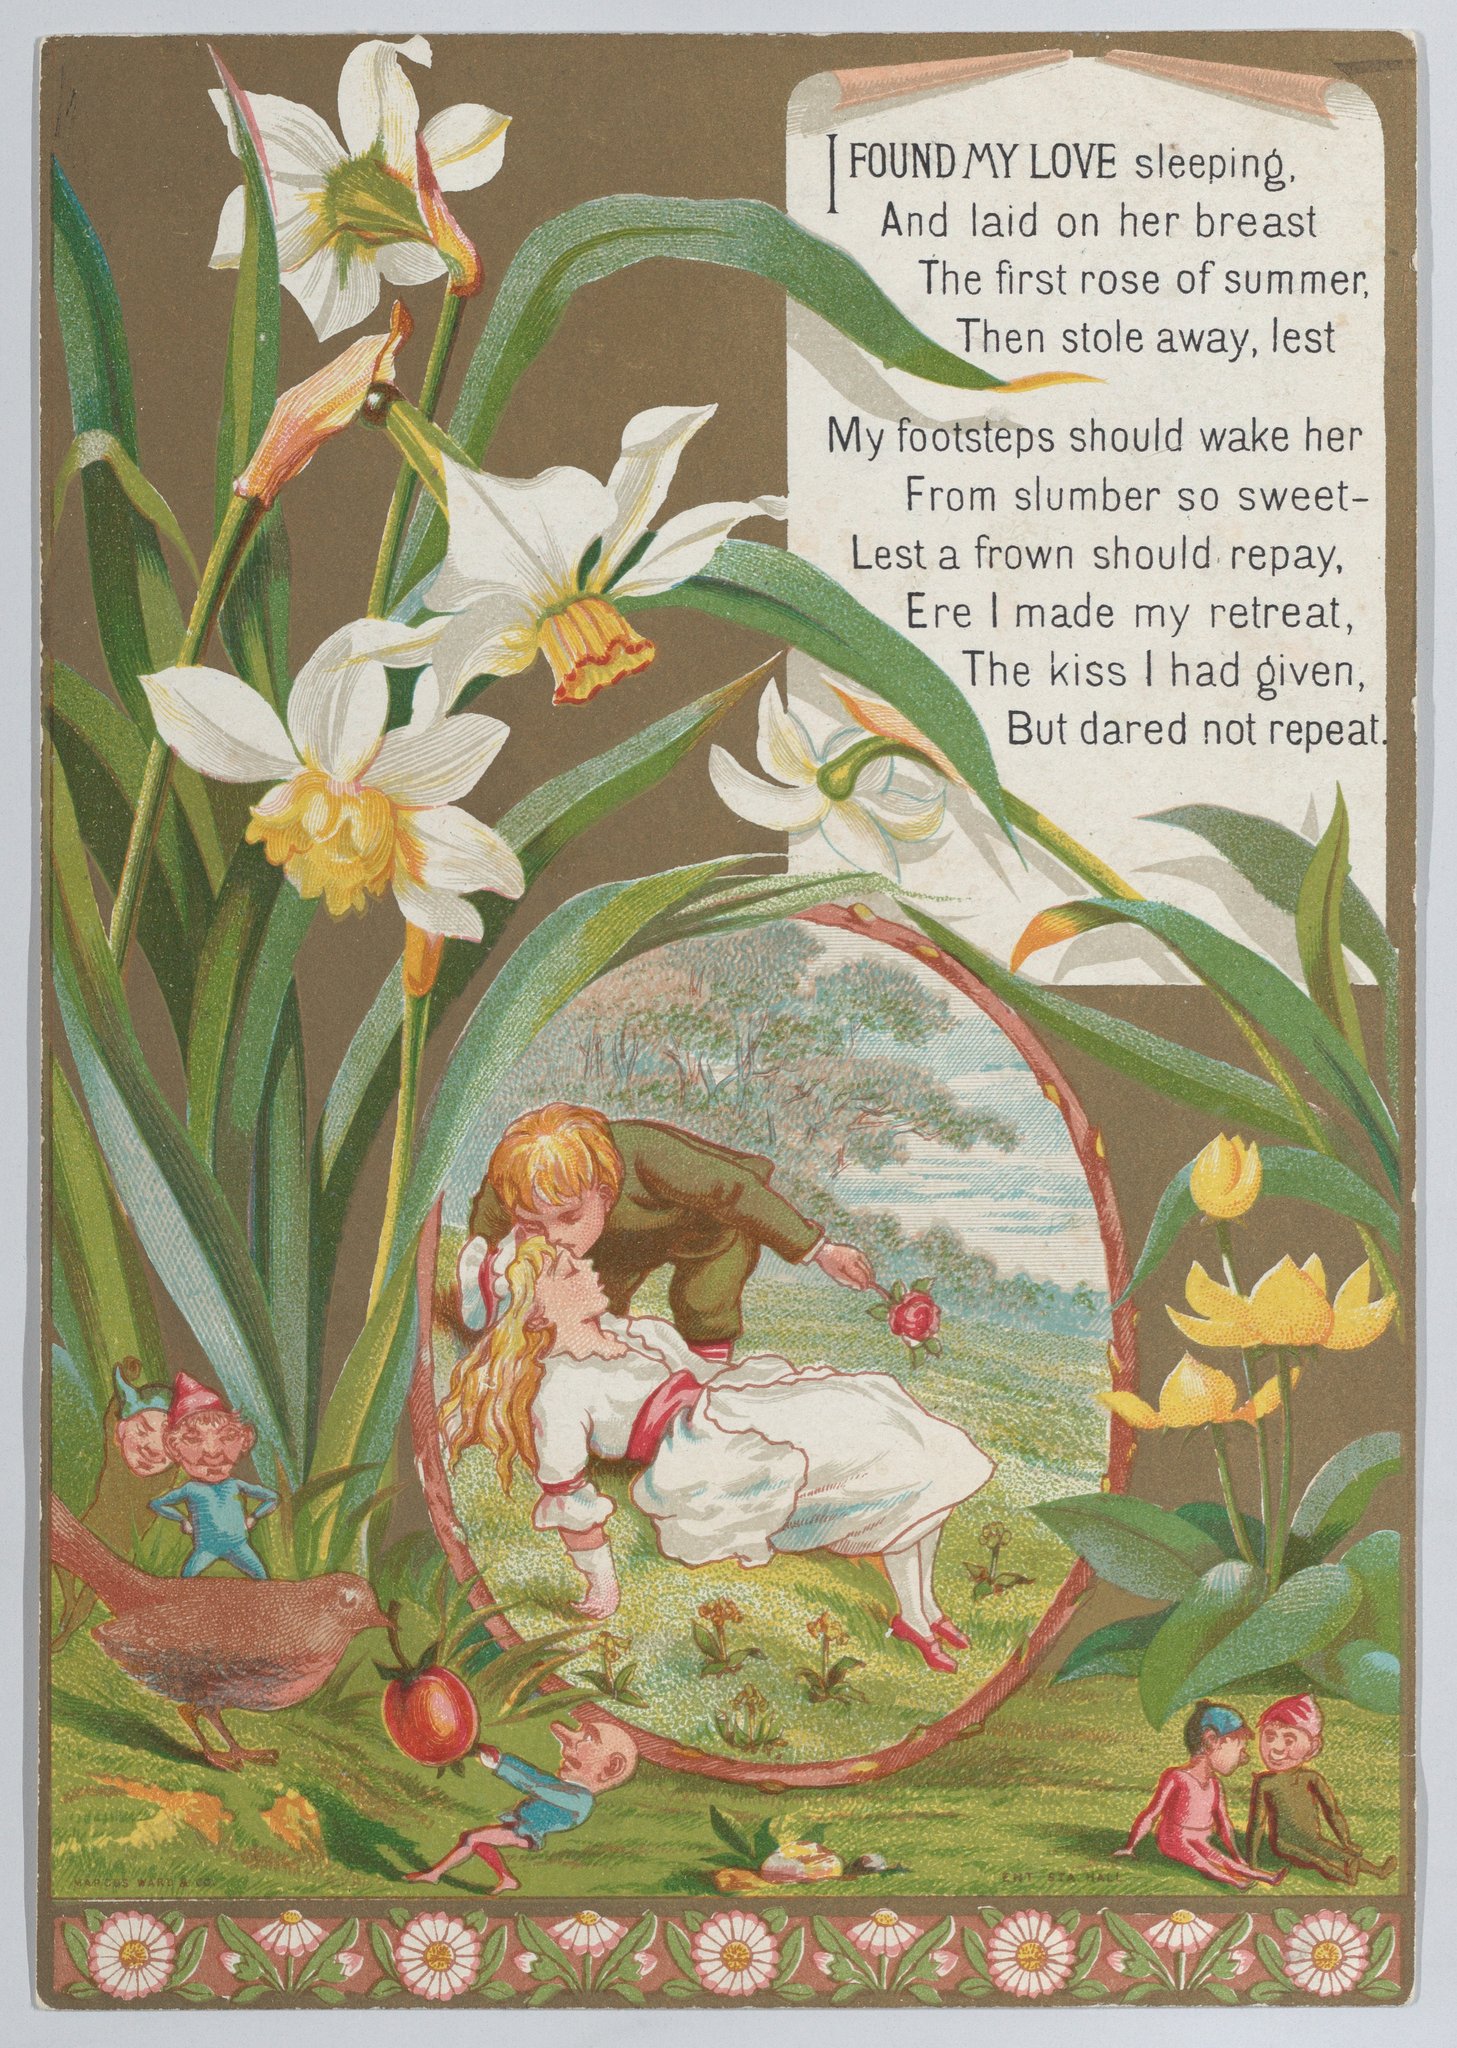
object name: valentine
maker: kate greenaway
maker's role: artist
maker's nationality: british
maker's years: 1846-1901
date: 1874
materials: gold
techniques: chromolithography, lithograph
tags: poetry,boys,girls,flowers